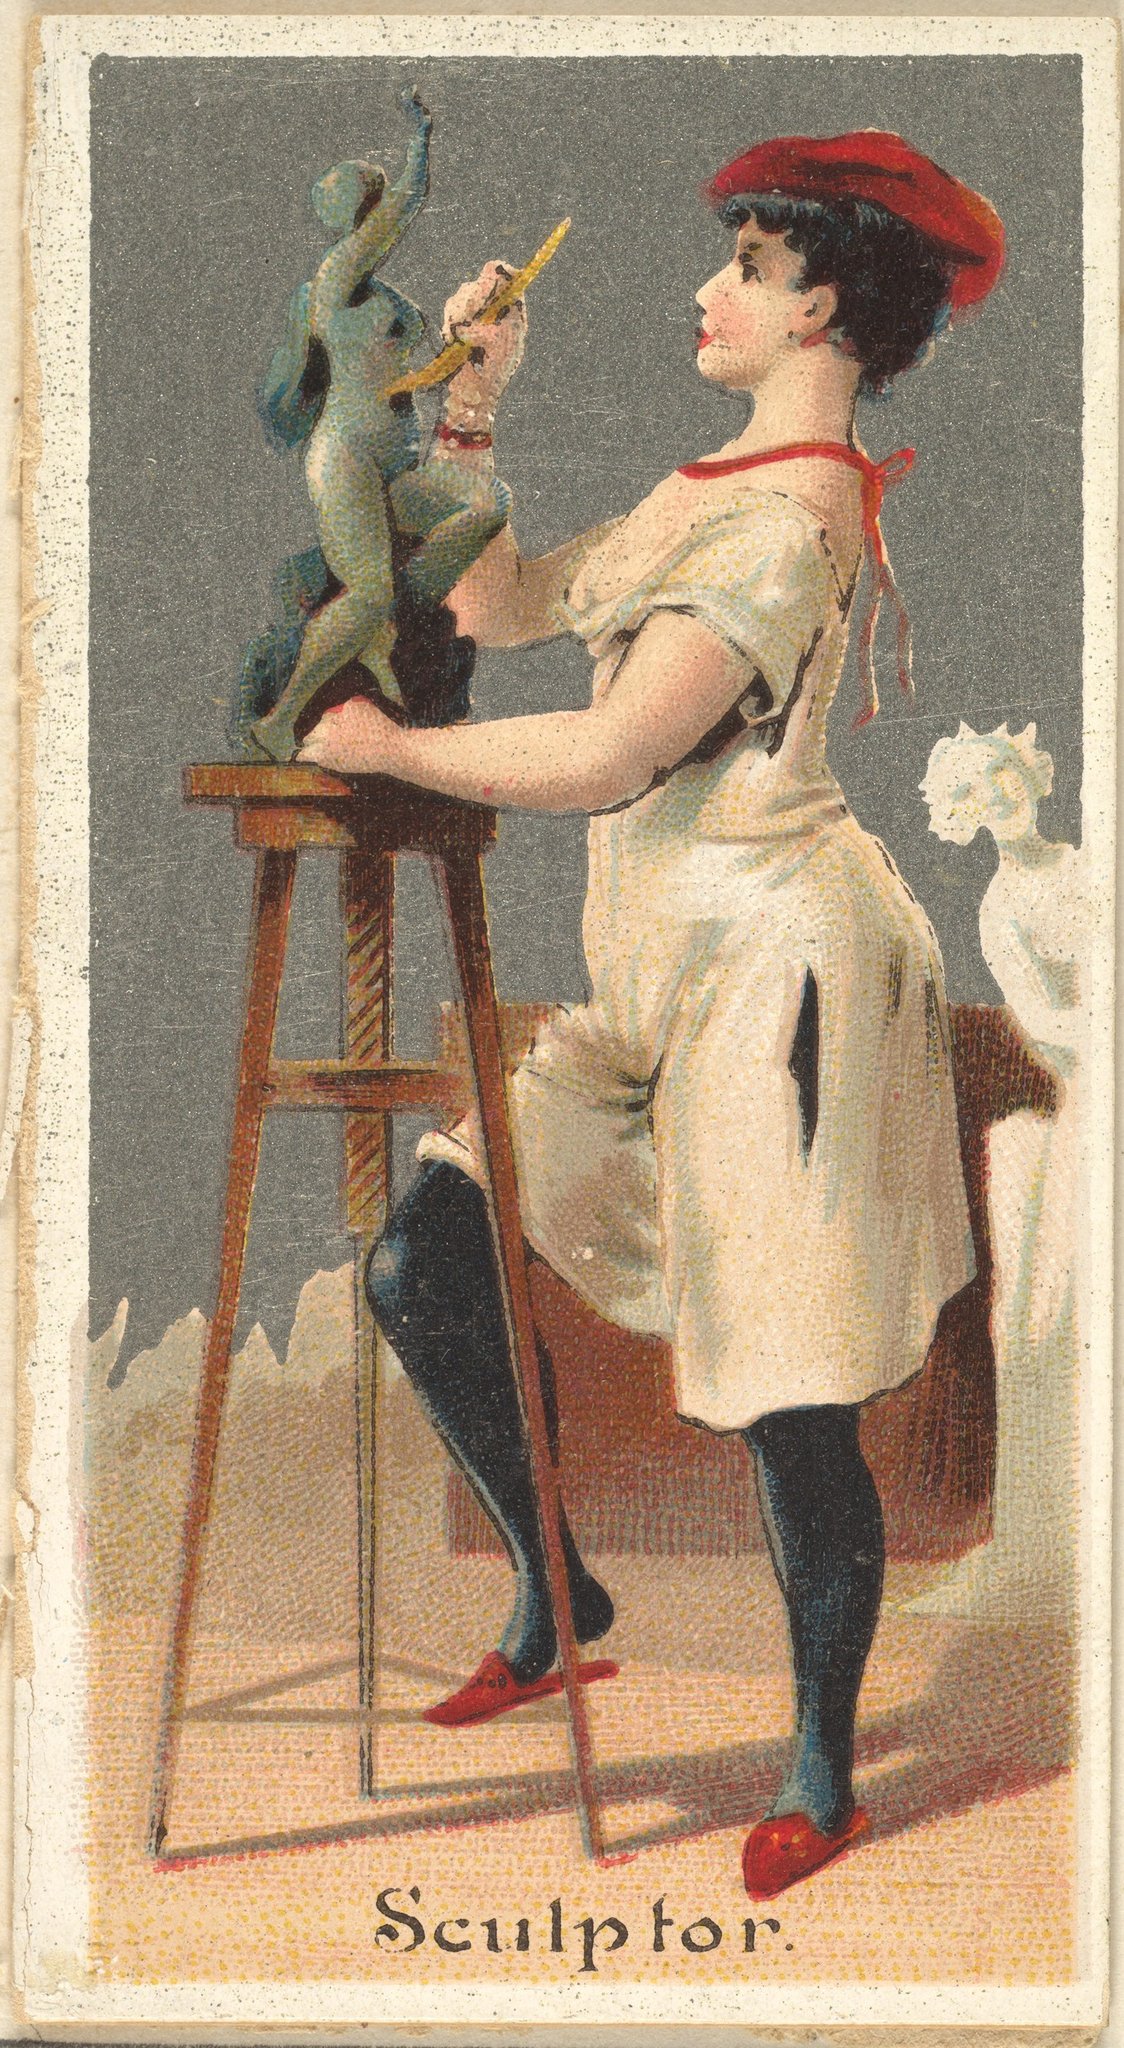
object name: print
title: Sculptor, from the Occupations for Women series (N166) for Old Judge and Dogs Head Cigarettes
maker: goodwin & company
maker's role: publisher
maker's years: 1850-1950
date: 1887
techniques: color lithograph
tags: sculpture,profiles,women